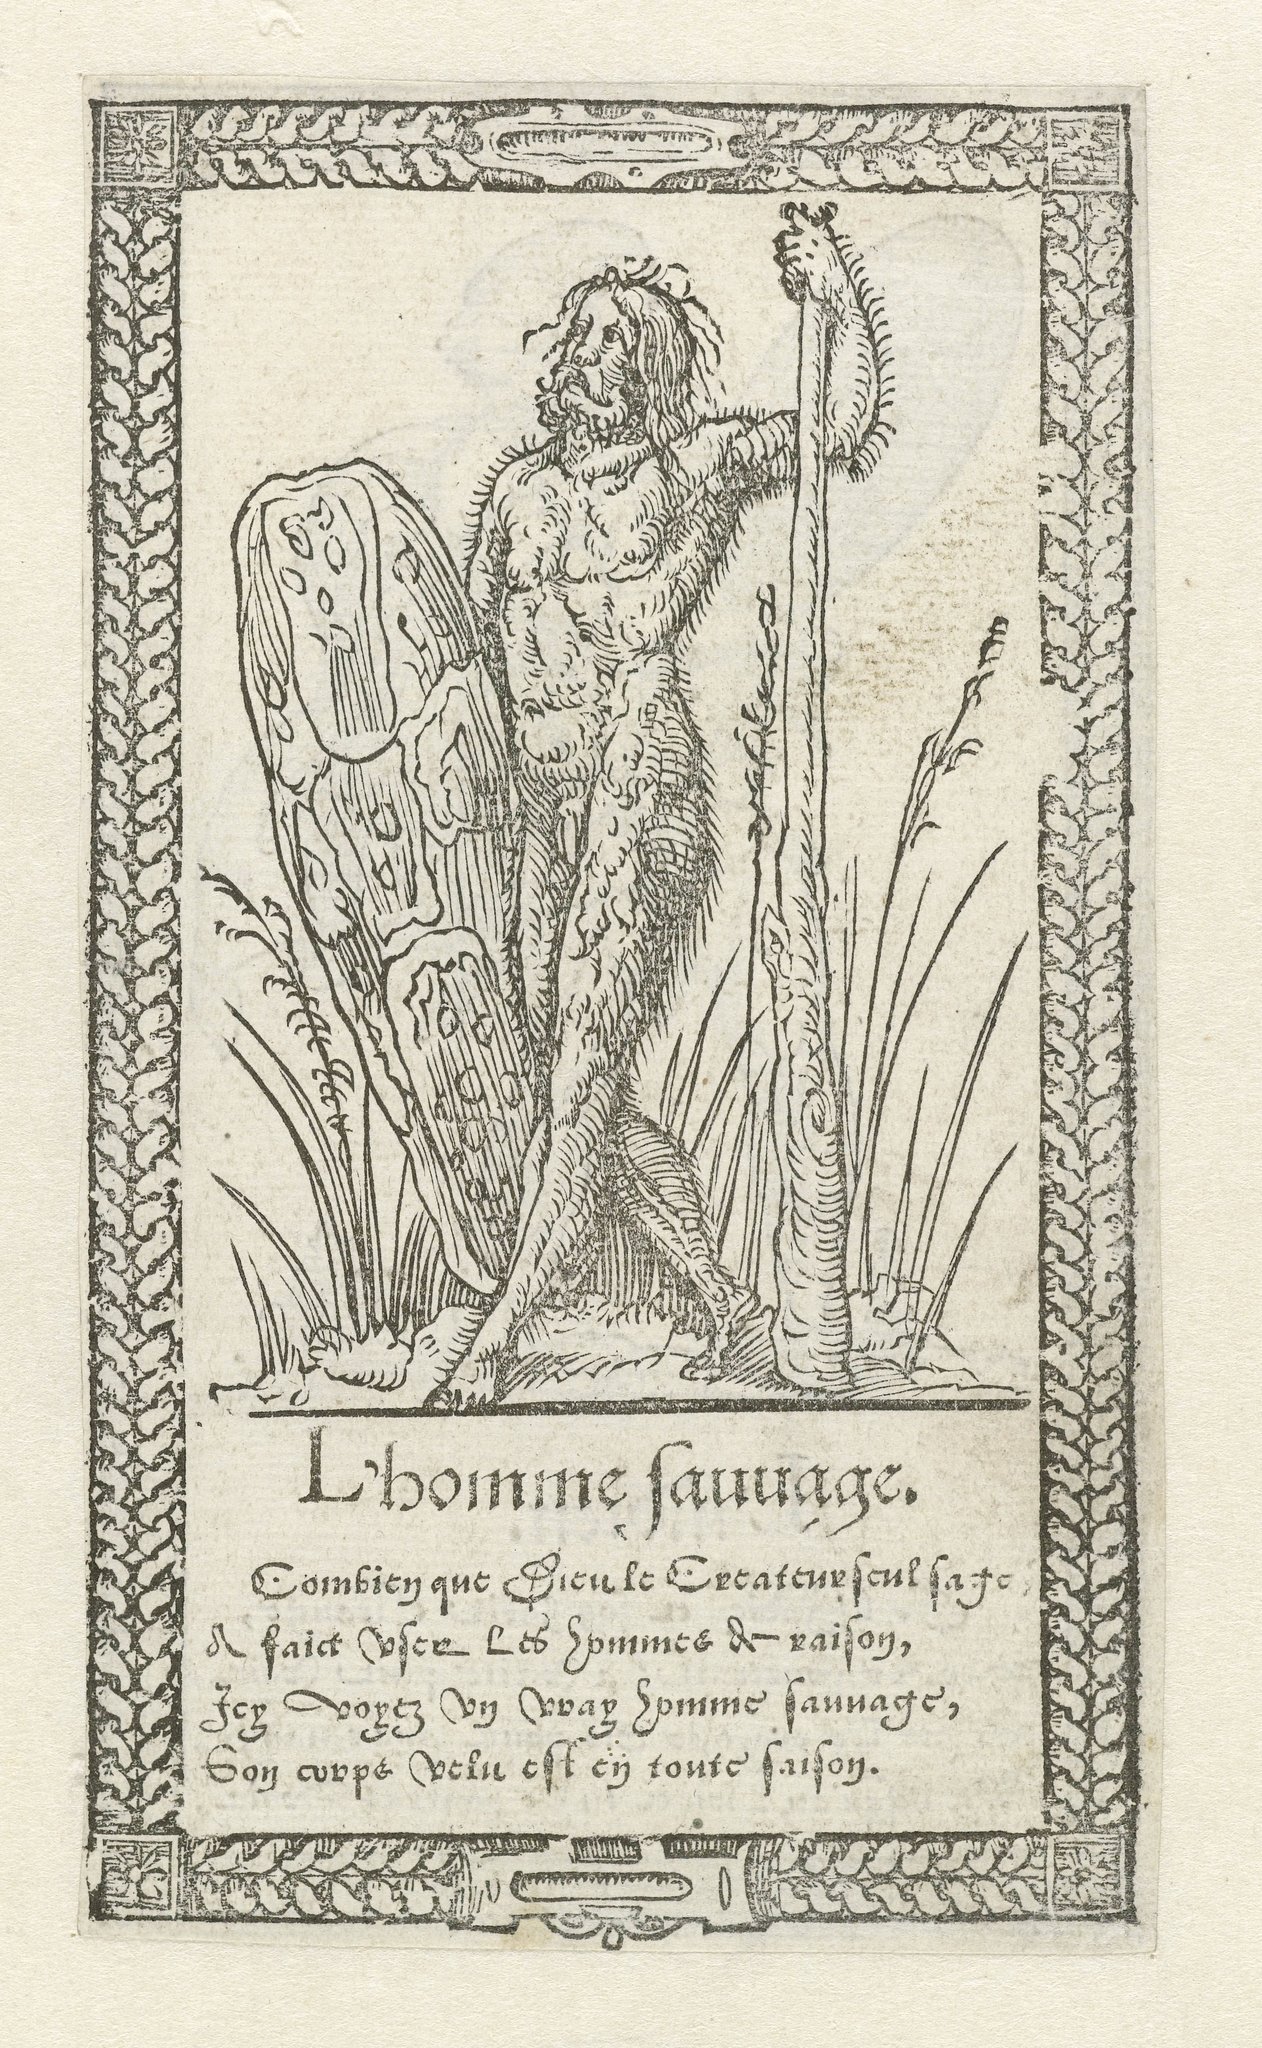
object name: print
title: Recueil de la diversité des habits (A Collection of the Various Styles of Clothing)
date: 1562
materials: paper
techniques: woodcut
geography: paris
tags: wild man, wodewose, woodehouse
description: This is the very first costume book, with more than a hundred images of clothing from around the world. Below each figure are four lines of verse describing the country’s outfits or related customs. This was an age of unprecedented overseas exploration. Europeans were especially fascinated to see and read about inhabitants of the so-called New World, such as the Brazilian woman with her child 1.